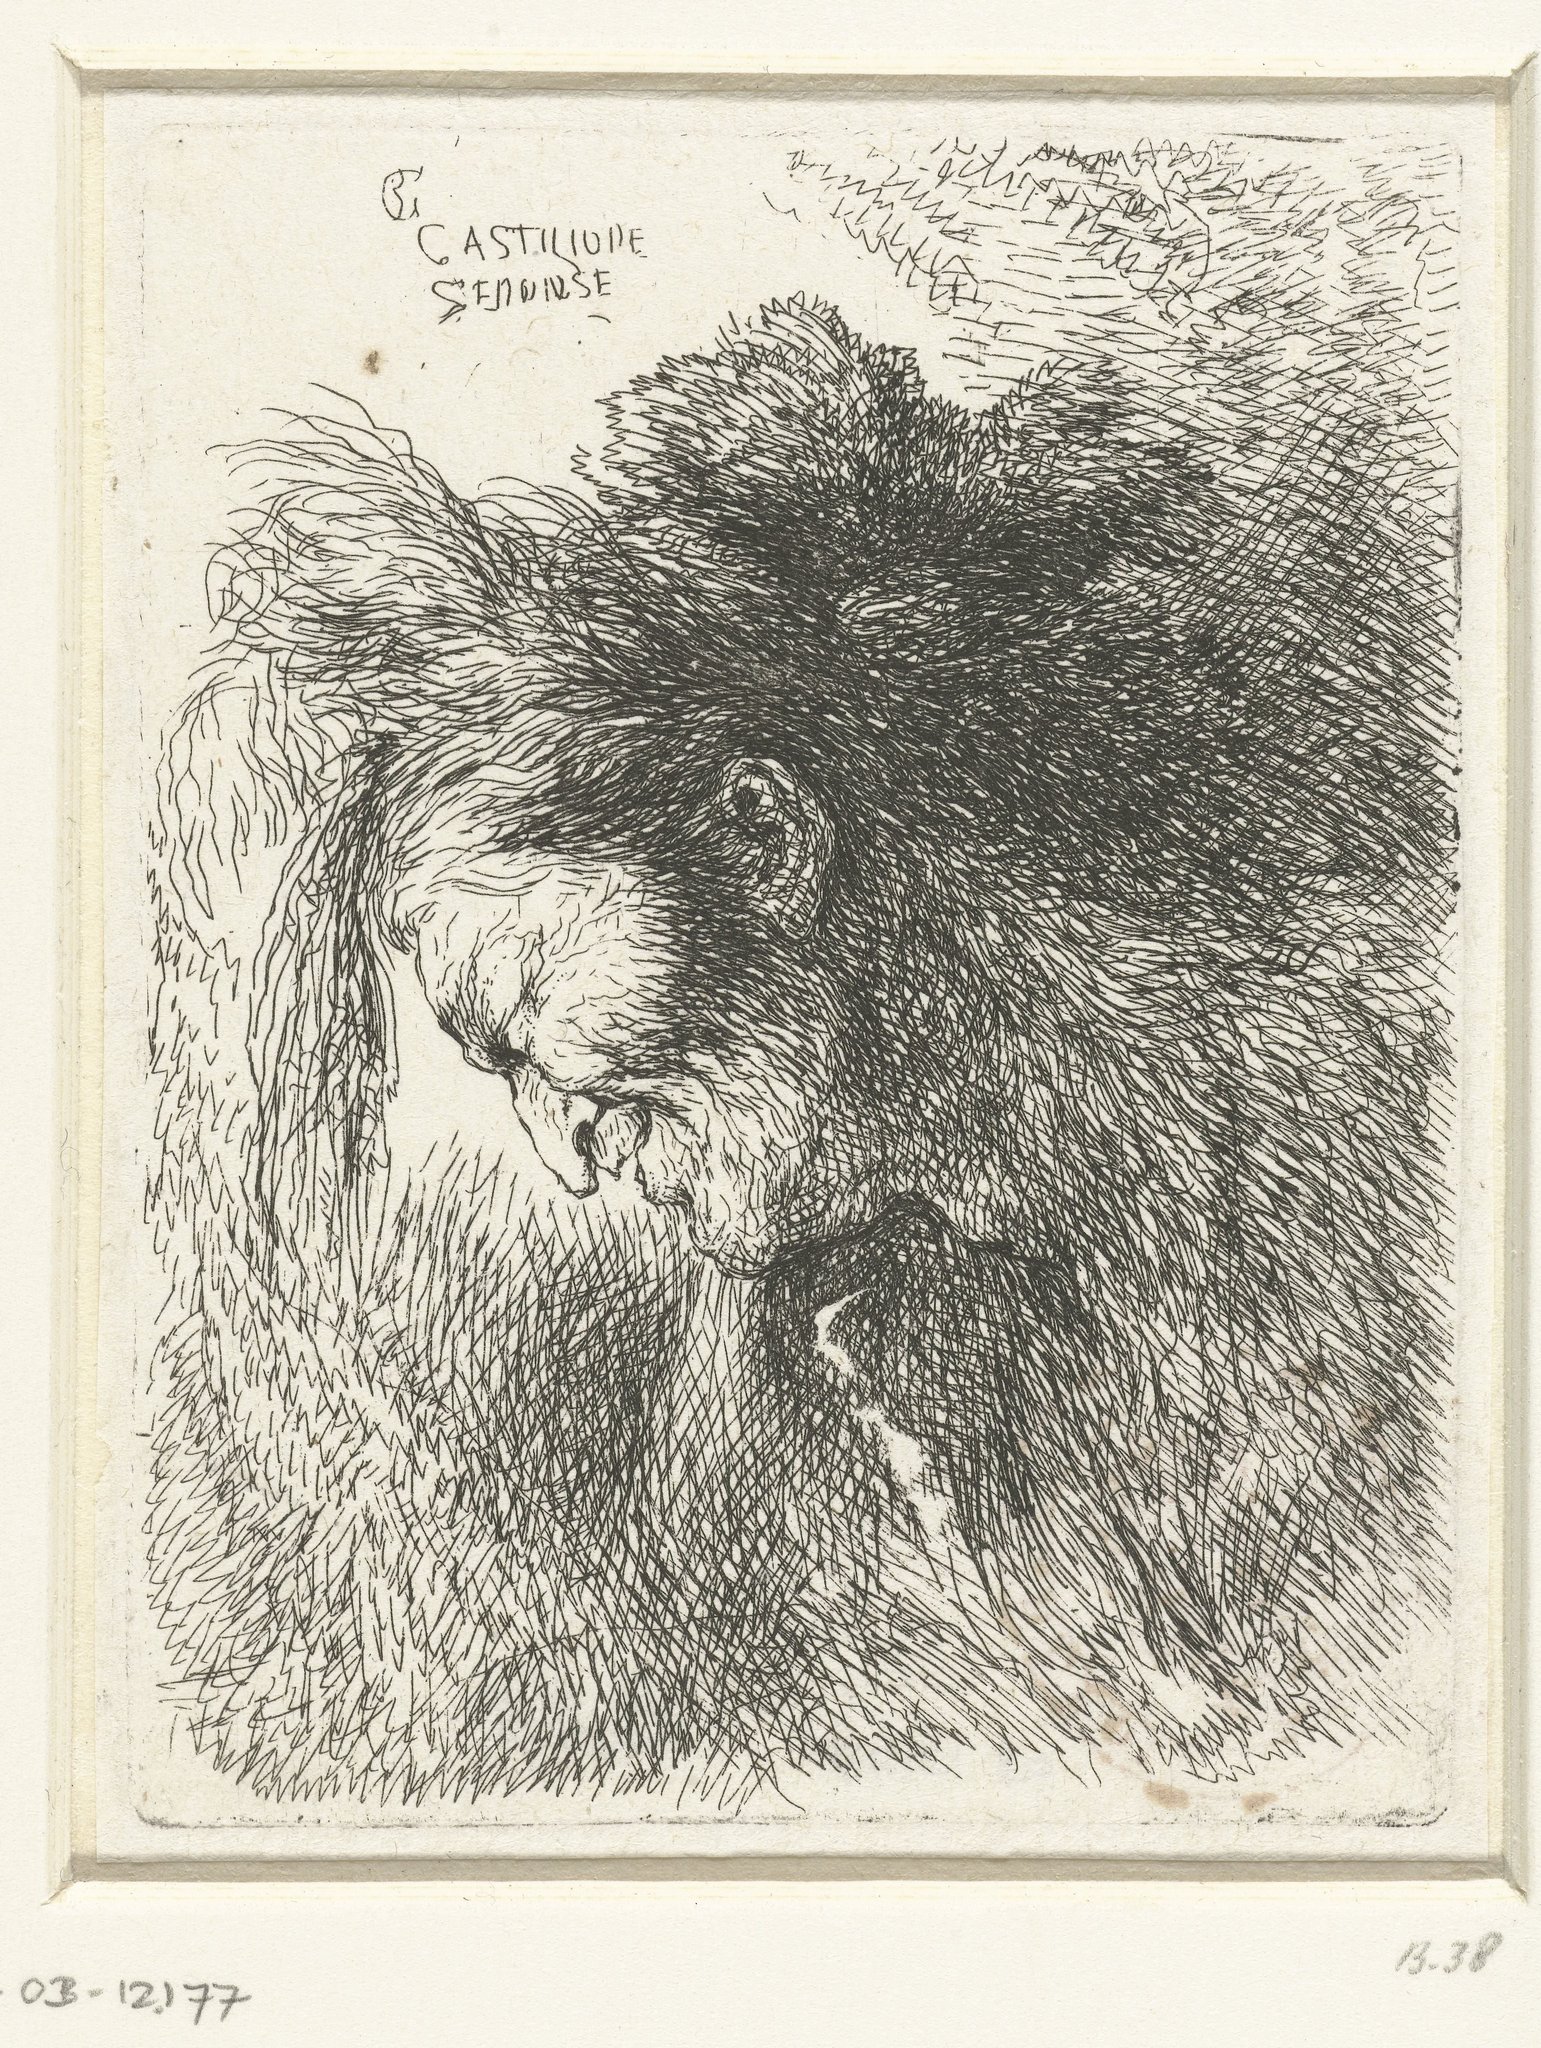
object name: print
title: Hoofd van een oude vrouw met een bontmuts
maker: giovanni benedetto castiglione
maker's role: draughtsman, print maker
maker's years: 1610-1665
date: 1645-1650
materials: paper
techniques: etching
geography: italy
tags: head (human), head-gear: cap (+ women's clothes), head-gear: cap (+ fur used for clothes)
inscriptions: collector's mark: Lugt 240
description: Deze serie van hoofden met oosterse hoofddeksels is geïnspireerd op soortgelijke etsen van Rembrandt en Lievens.